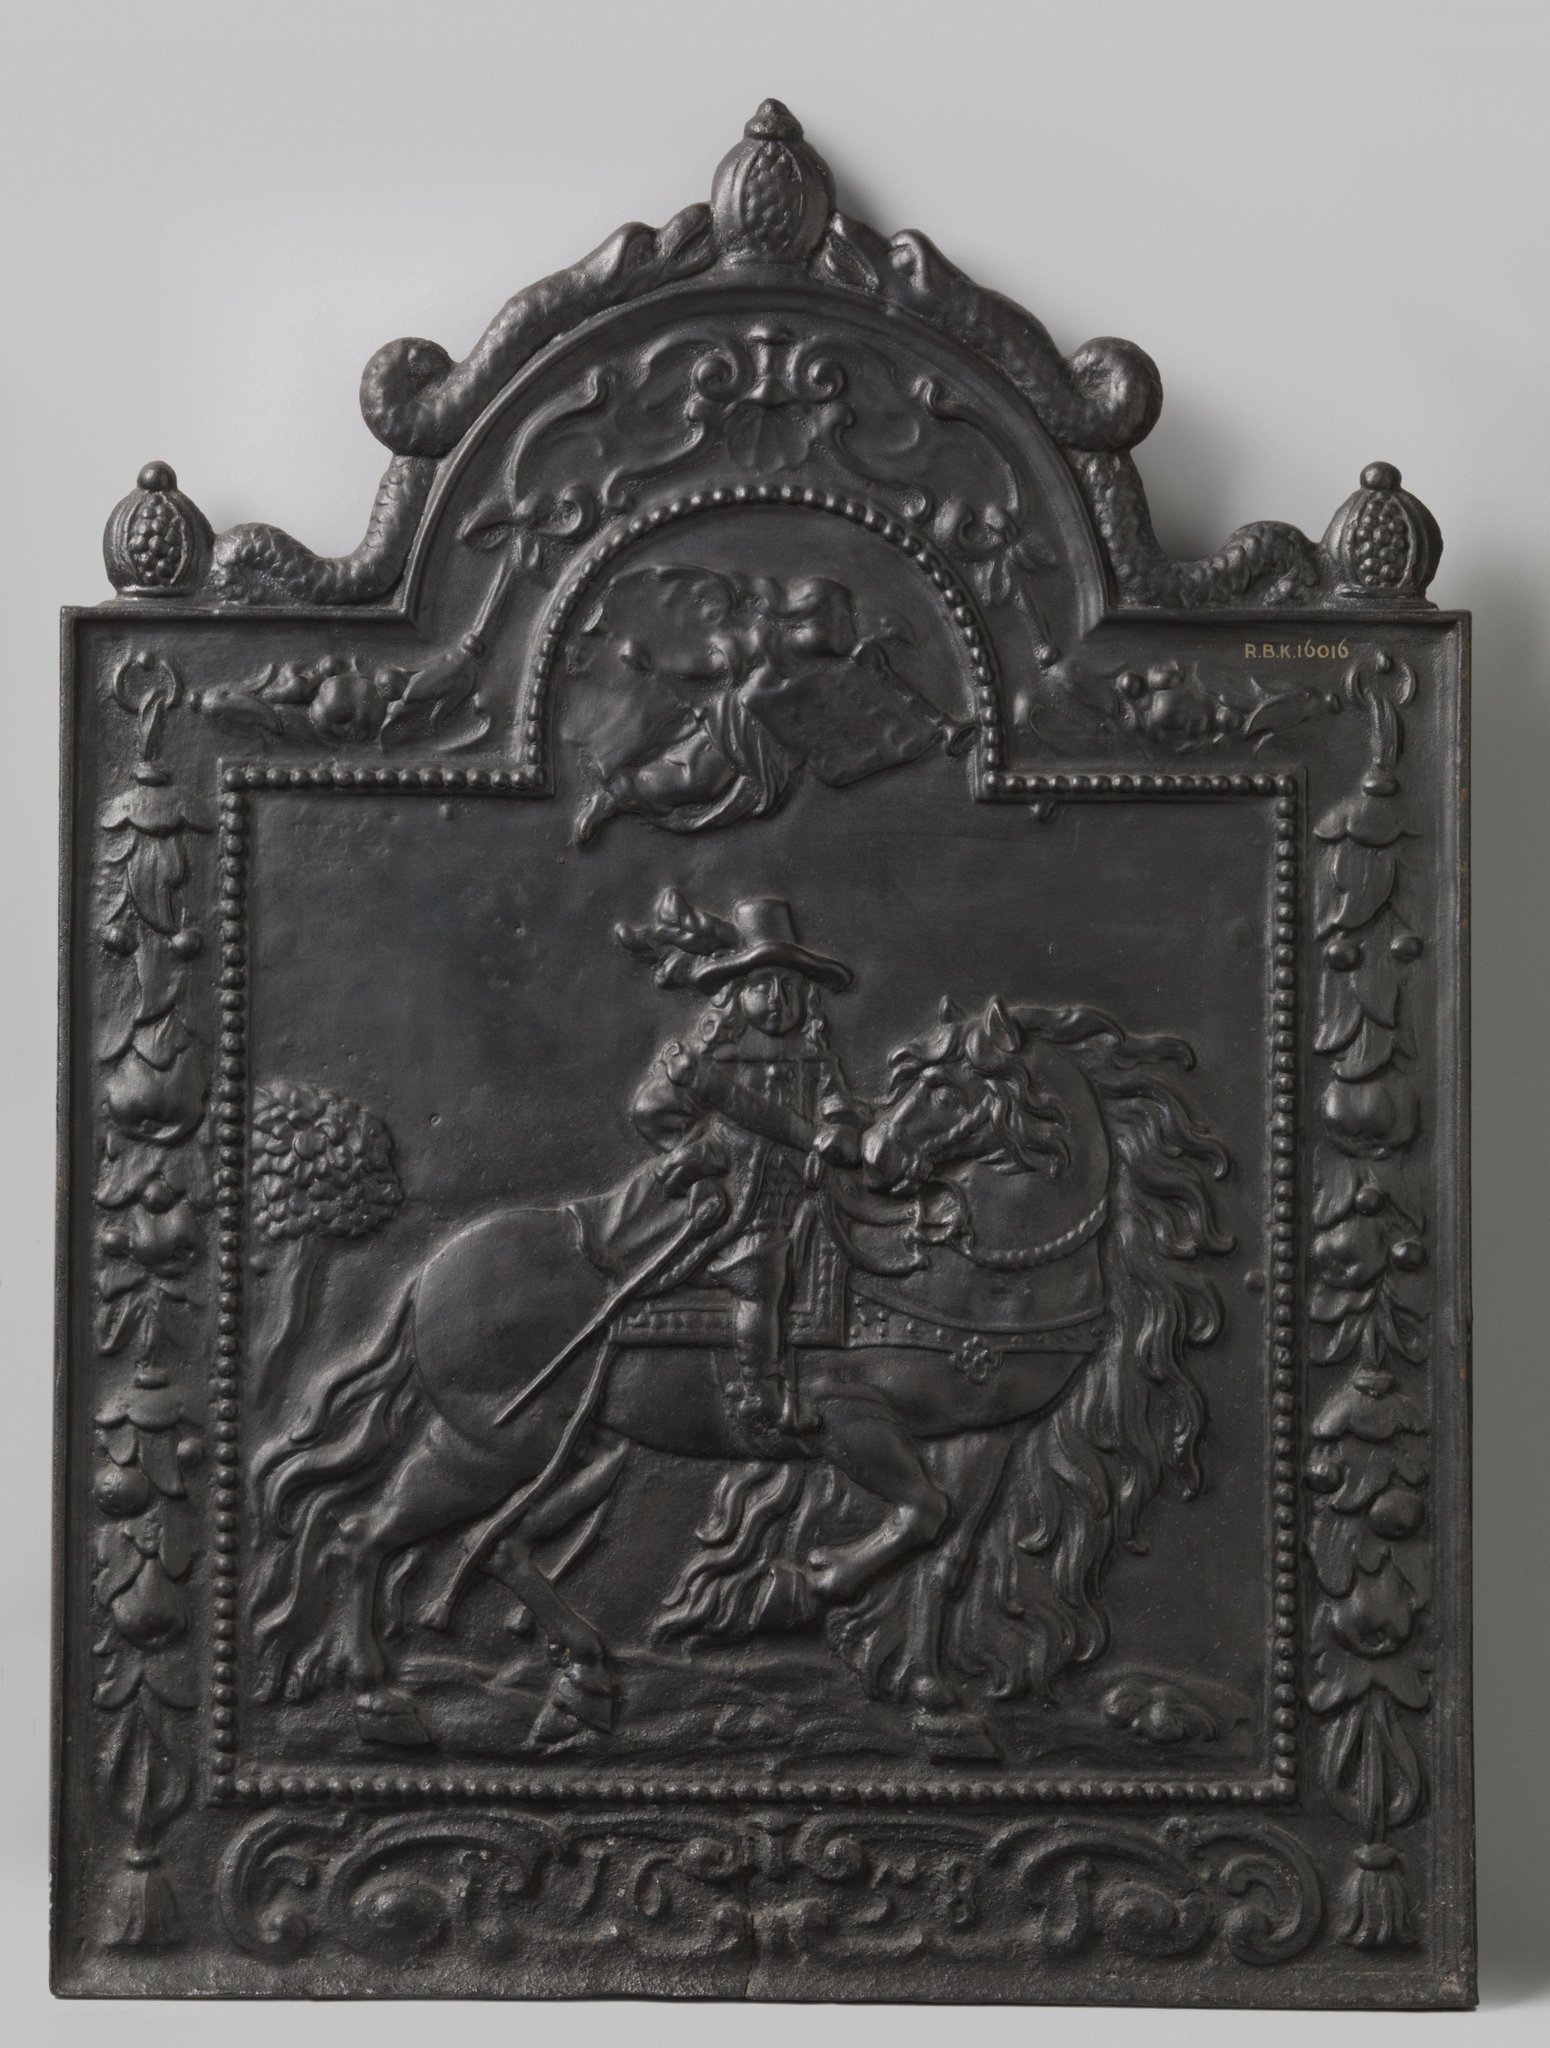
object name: fireback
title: Haardplaat met een jonge Willem III te paard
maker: Anonymous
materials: iron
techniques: casting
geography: germany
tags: the hague, william iii (prince of orange and king of england, scotland, and ireland)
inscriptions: inscription: ‘VIVE LE PRINCE D'ORANGE’, inscription: ‘1658’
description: Haardplaat van gietijzer, met een halfronde bovenzijde. Centraal staat een naar rechts lopend paard met daarop een prins van Oranje, zeer waarschijnlijk een jonge Willem III. Links wordt het tafereel afgesloten met een boom. Bovenaan zweeft Faam, blazend op een trompet met daaraan een vaandel met opschrift: VIVE LE PRINCE D'ORANGE. Het geheel is omlijst met een rand, versierd met een parelrand en aan weerszijden een festoen, boven- en onderaan bladranken. In de bladranken onderaan staat het jaartal 1658. De bovenzijde wordt bekroond met drie granaatappels en aan weerszijden twee opklimmende dolfijnen.